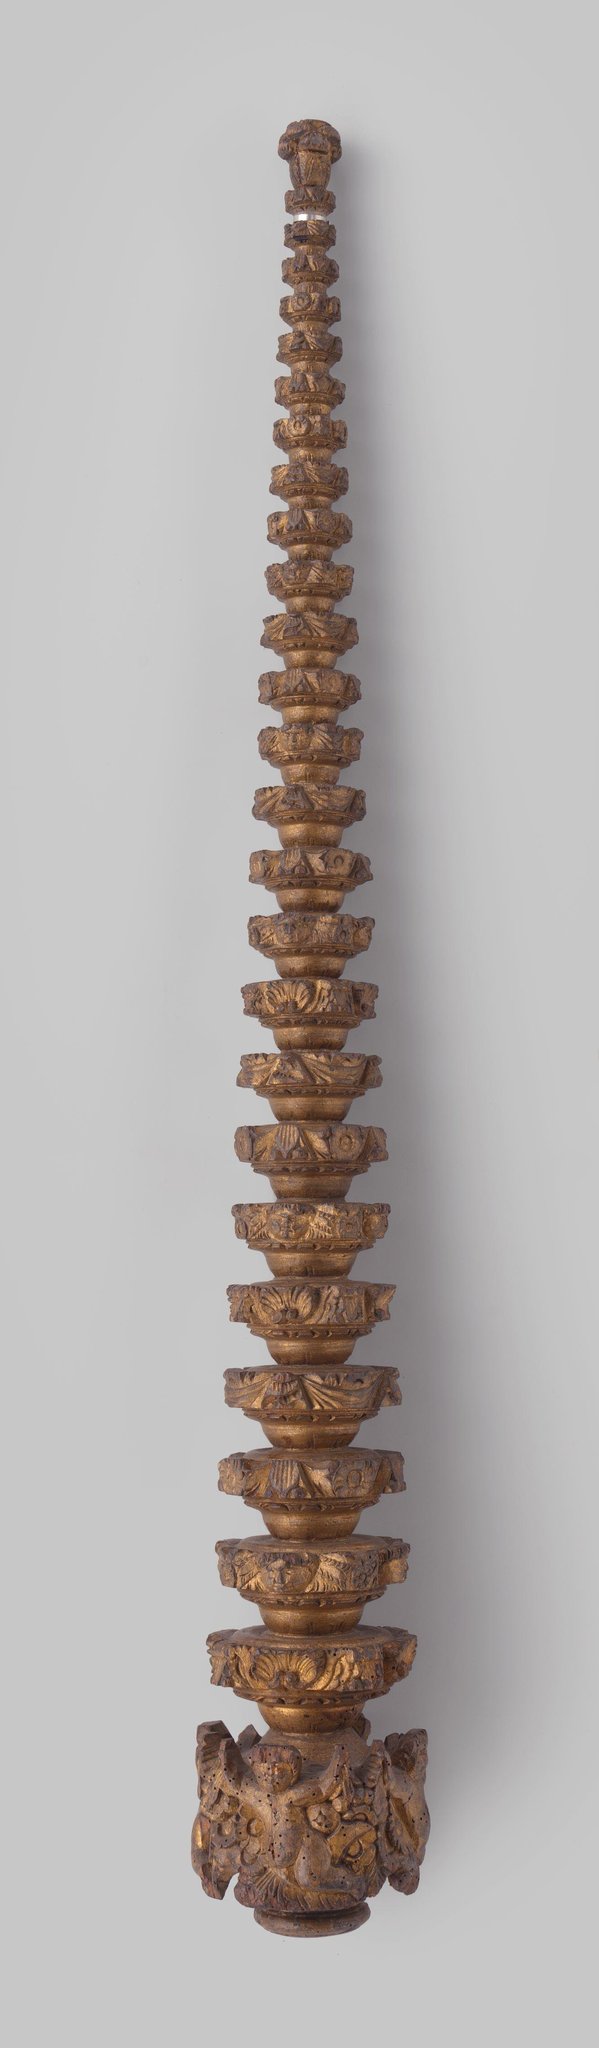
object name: mastwortel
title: Mastwortel van een boeier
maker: Anonymous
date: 1700-1800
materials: iron, wood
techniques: cutting, gilding, turning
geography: netherlands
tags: netherlands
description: Vergulde mastwortel met 16 geledingen. De onderste (beschadigd) bestaat uit 4 putti met de armen omhoog, de anderen uit gestileerde plantmotieven. De 3e, 7e, 11e, 14e en 17e zijn voorzien van 4 puttikopjes. Onderin rond gat; bovenaan bekroning van bosje veren.